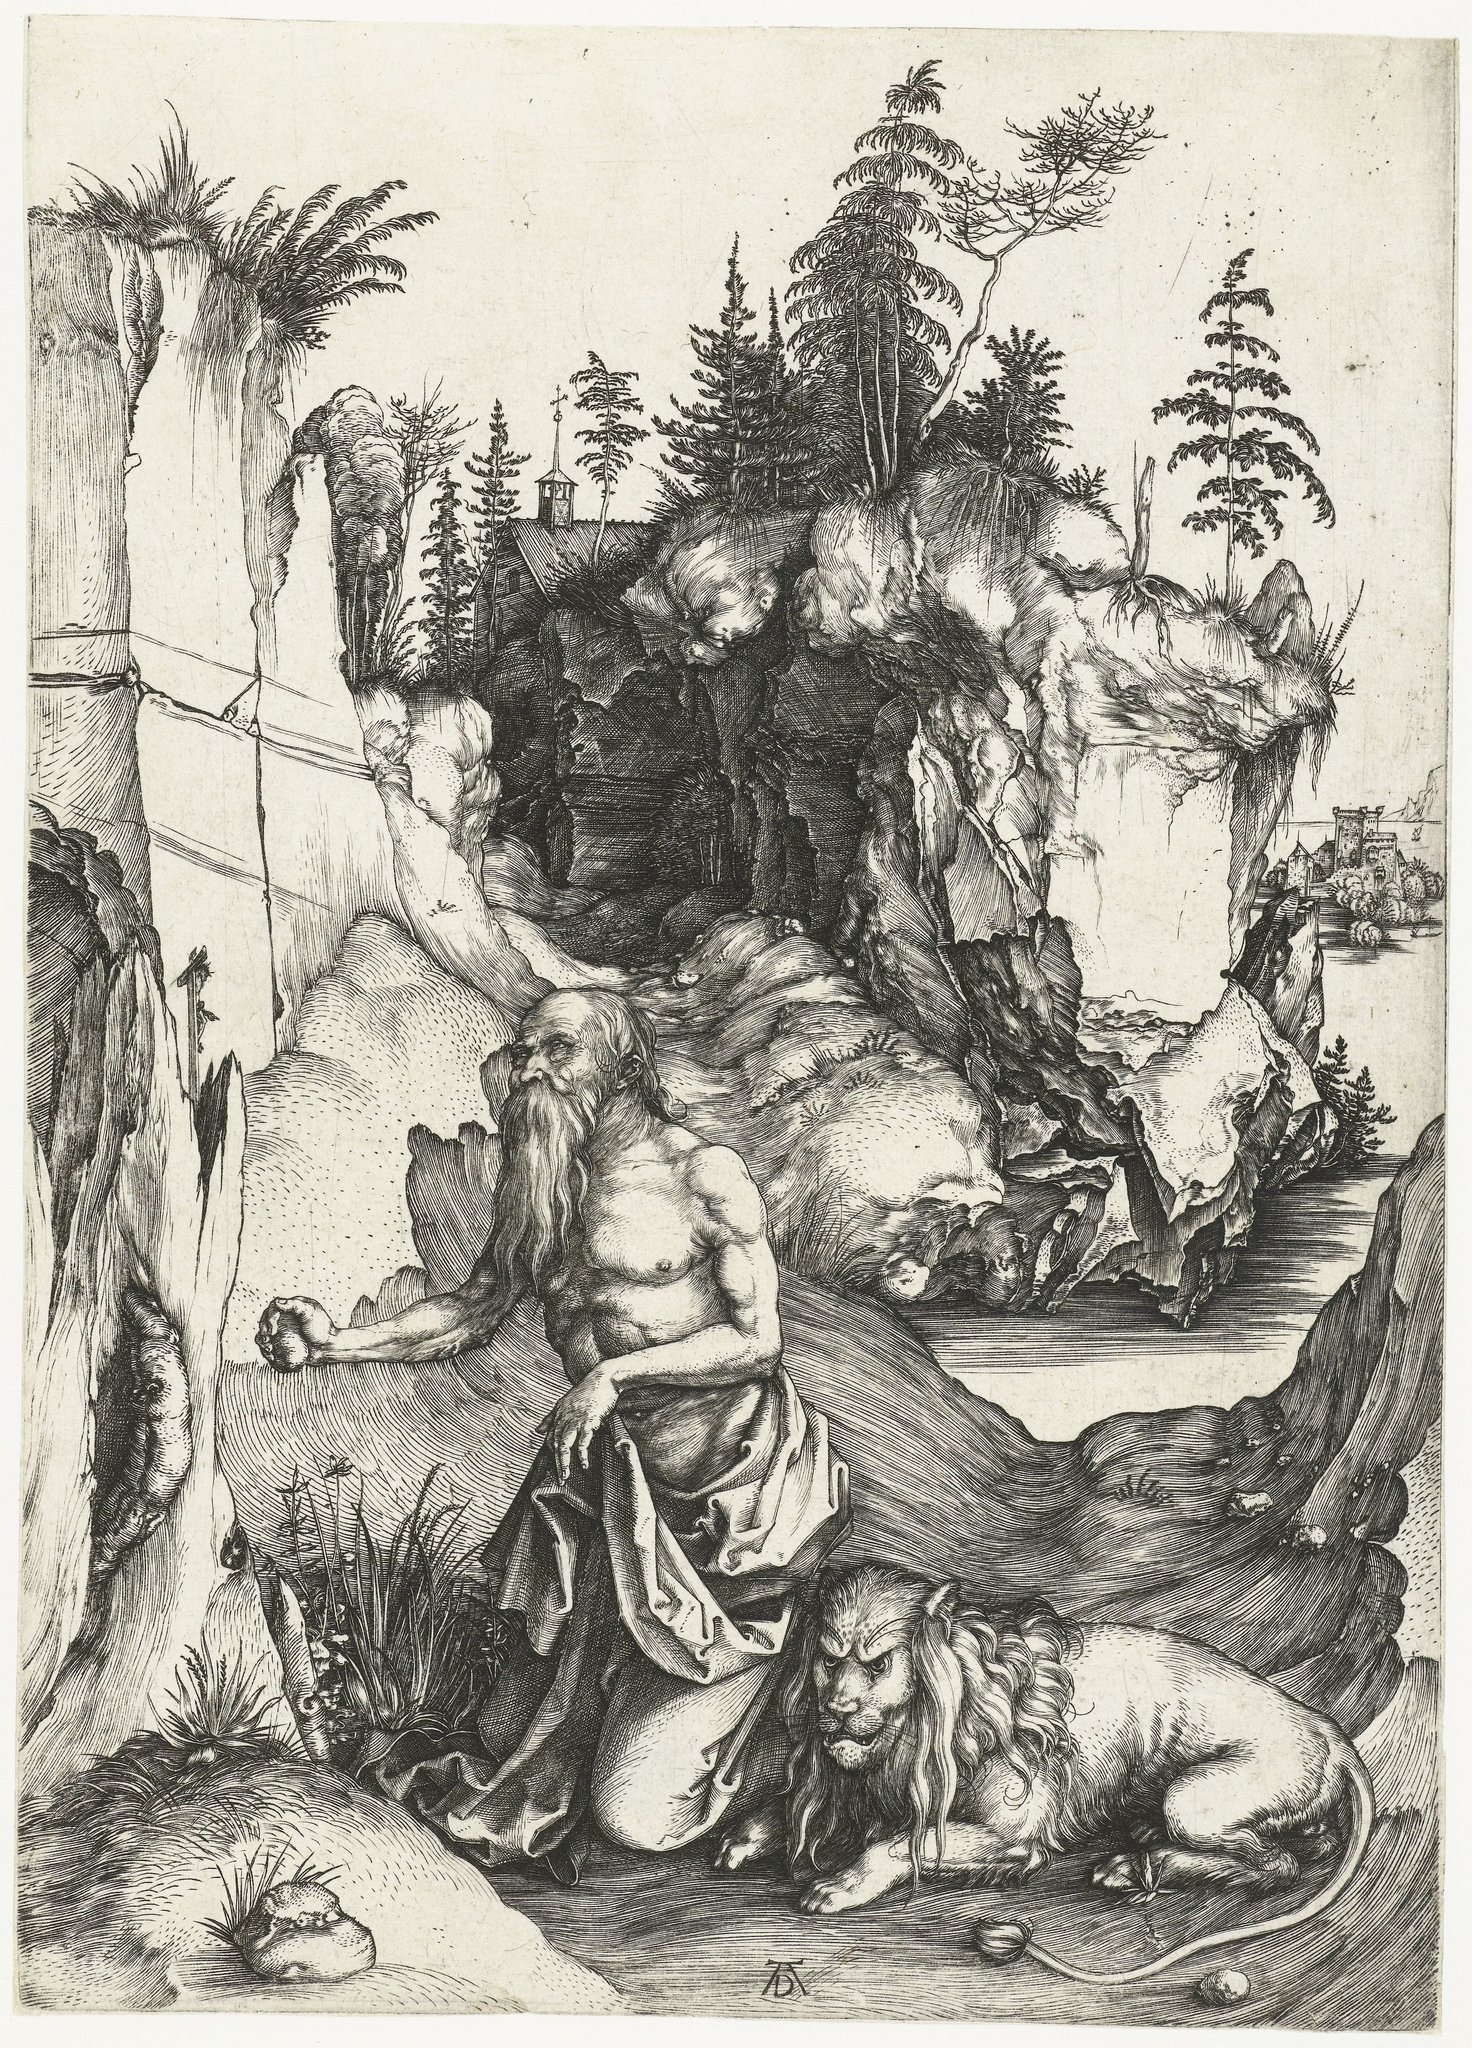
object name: print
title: De Heilige Hiëronymus in de wildernis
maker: albrecht dürer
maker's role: draughtsman, painter, print maker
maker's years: 1471-1528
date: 1494-1498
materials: paper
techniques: engraving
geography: nuremberg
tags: st. jerome as penitent in the desert, half naked, kneeling before a crucifix and holding a stone in his hand to beat his breast; a skull (and other 'vanitas' symbols), sometimes a scorpion and a snake beside him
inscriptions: collector's mark: Lugt 240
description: De Heilige Hiëronymus zit op zijn knieën in een rotsachtige omgeving bij een crucifix met een steen in zijn hand. Aan zijn voeten ligt een leeuw. Op de achtergrond links een kerkje, op de achtergrond rechts een burcht aan een water.